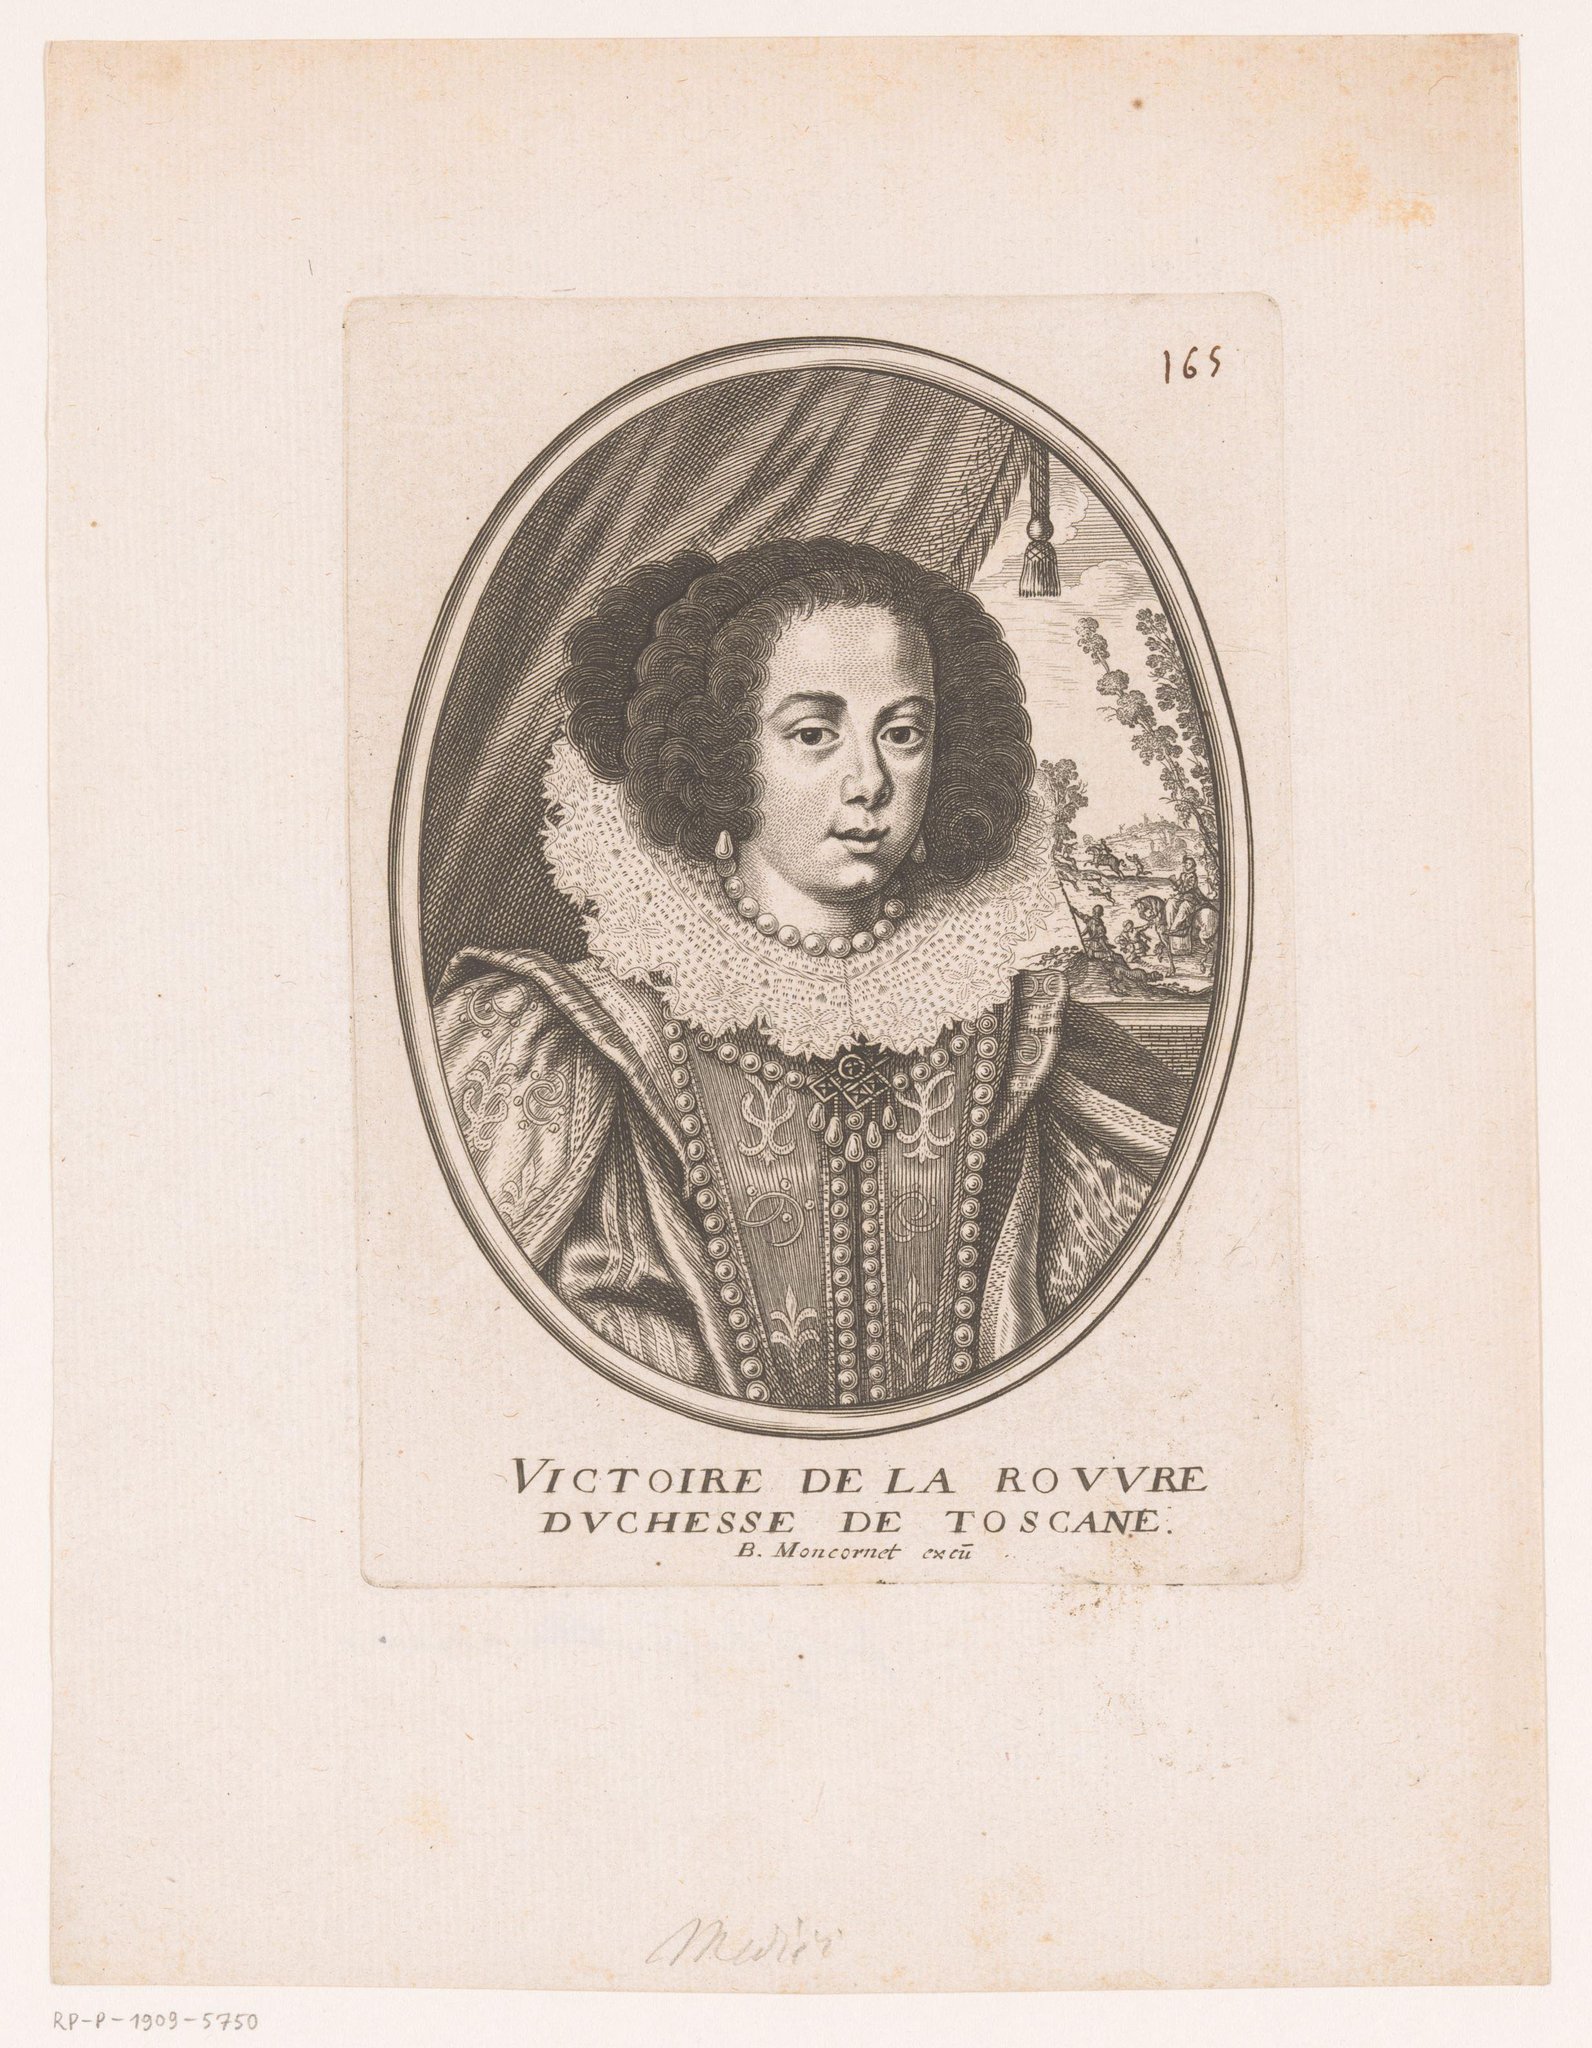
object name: print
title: Portret van Vittoria della Rovere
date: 1642-1668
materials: paper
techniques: engraving, etching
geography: paris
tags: historical persons - bb - woman, nobility and patriciate; chivalry, knighthood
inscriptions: number: ‘165’, collector's mark: Lugt 2228